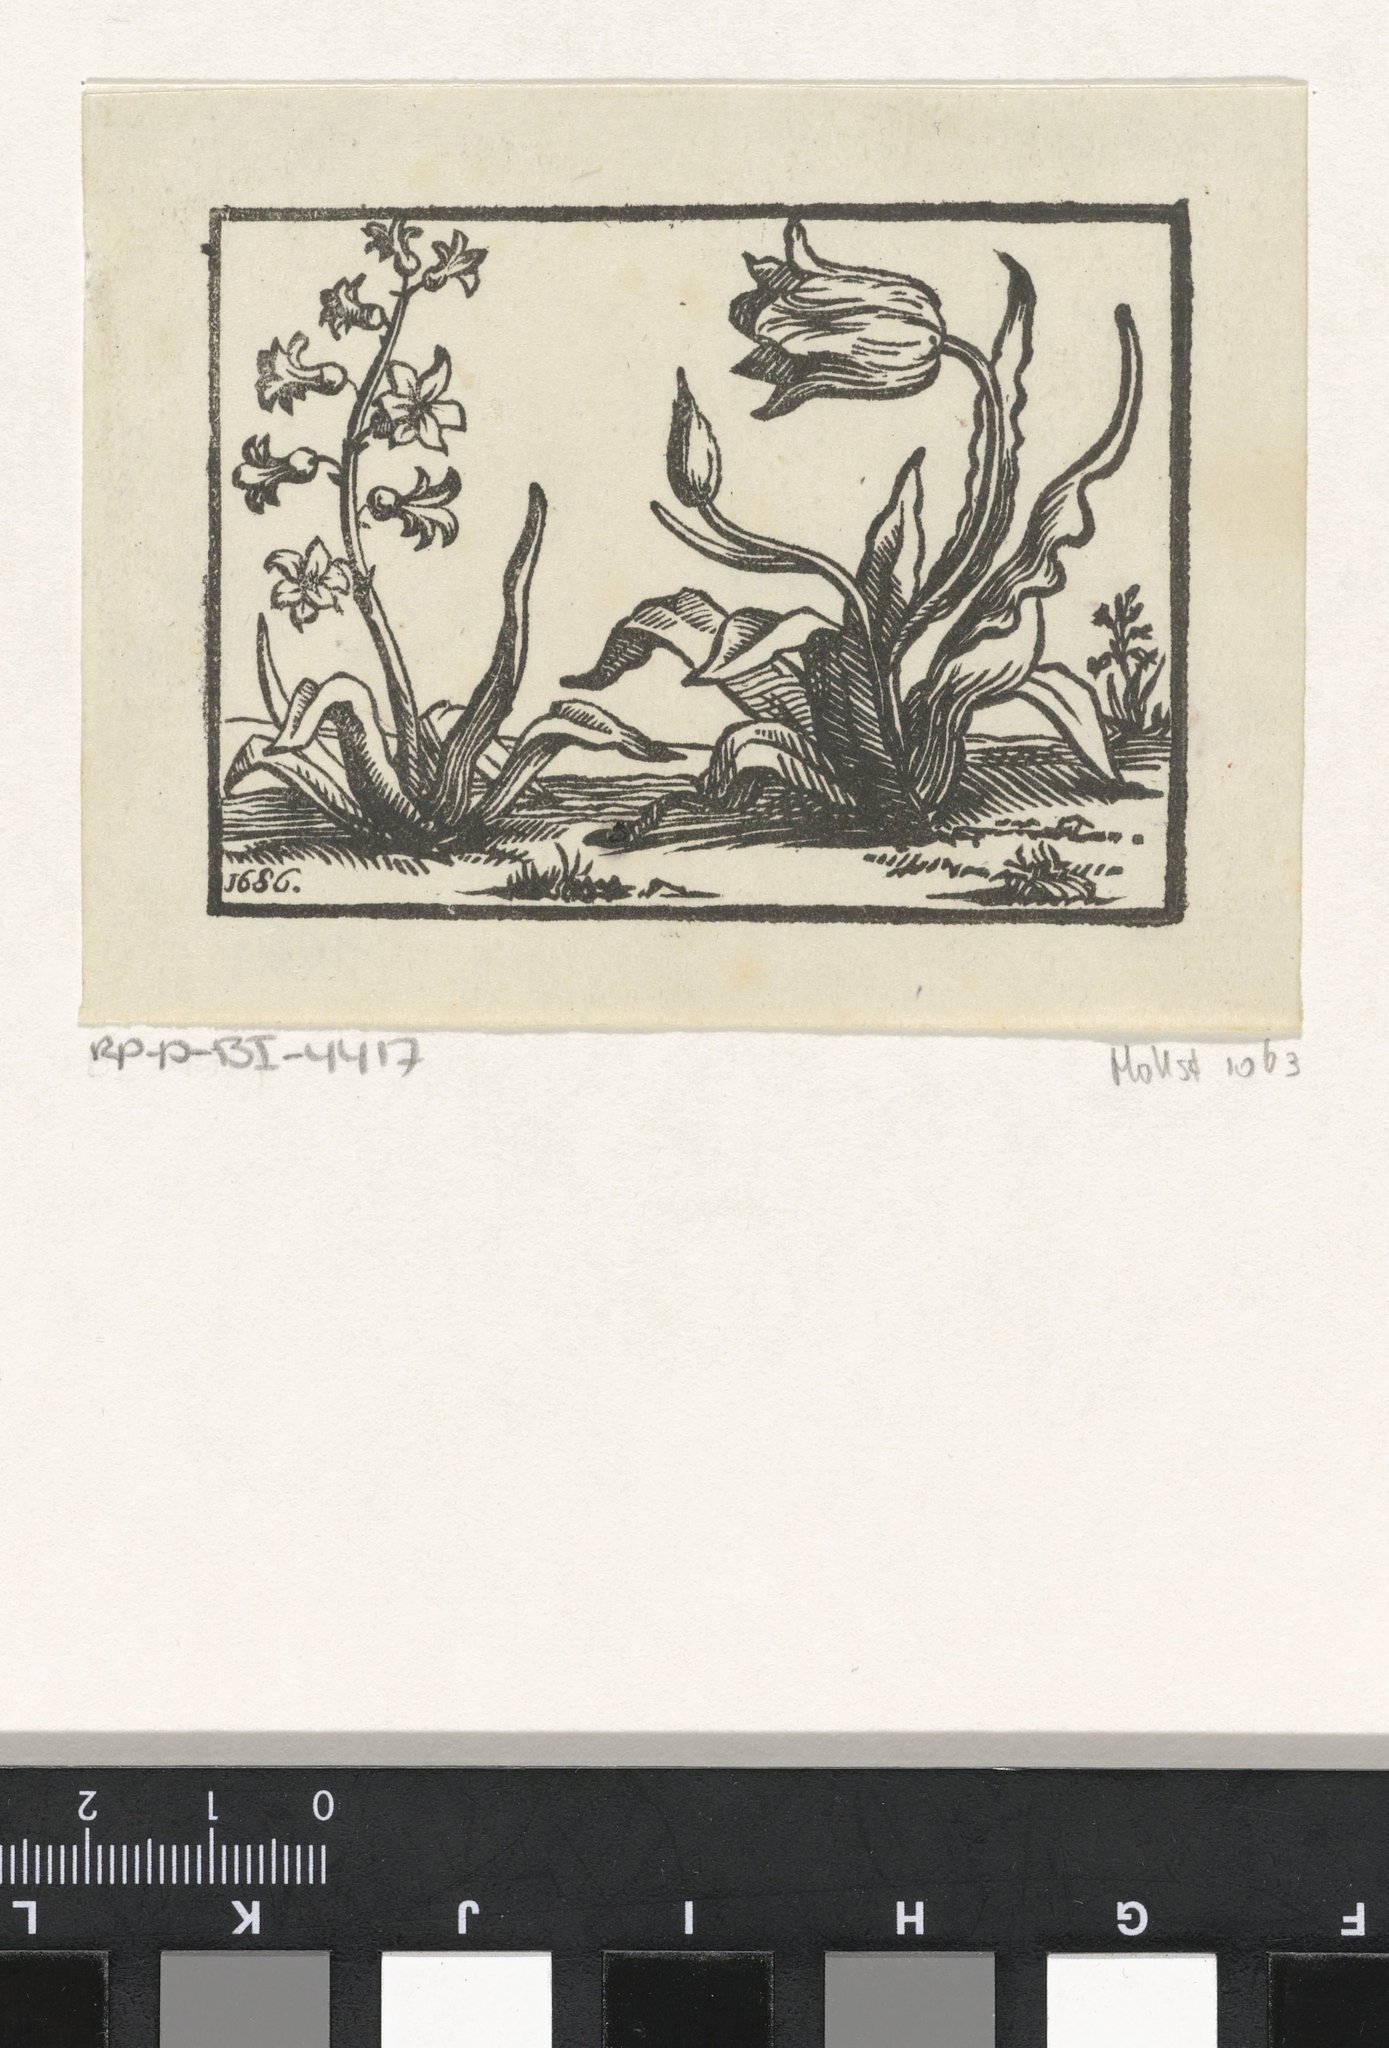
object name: print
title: Hyacint en een tulp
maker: isaac vincentsz. van der vinne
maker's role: draughtsman, print maker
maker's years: 1665-1740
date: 1686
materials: paper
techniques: woodcut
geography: haarlem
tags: flowers: tulip, flowers: hyacinth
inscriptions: collector's mark: Lugt 240